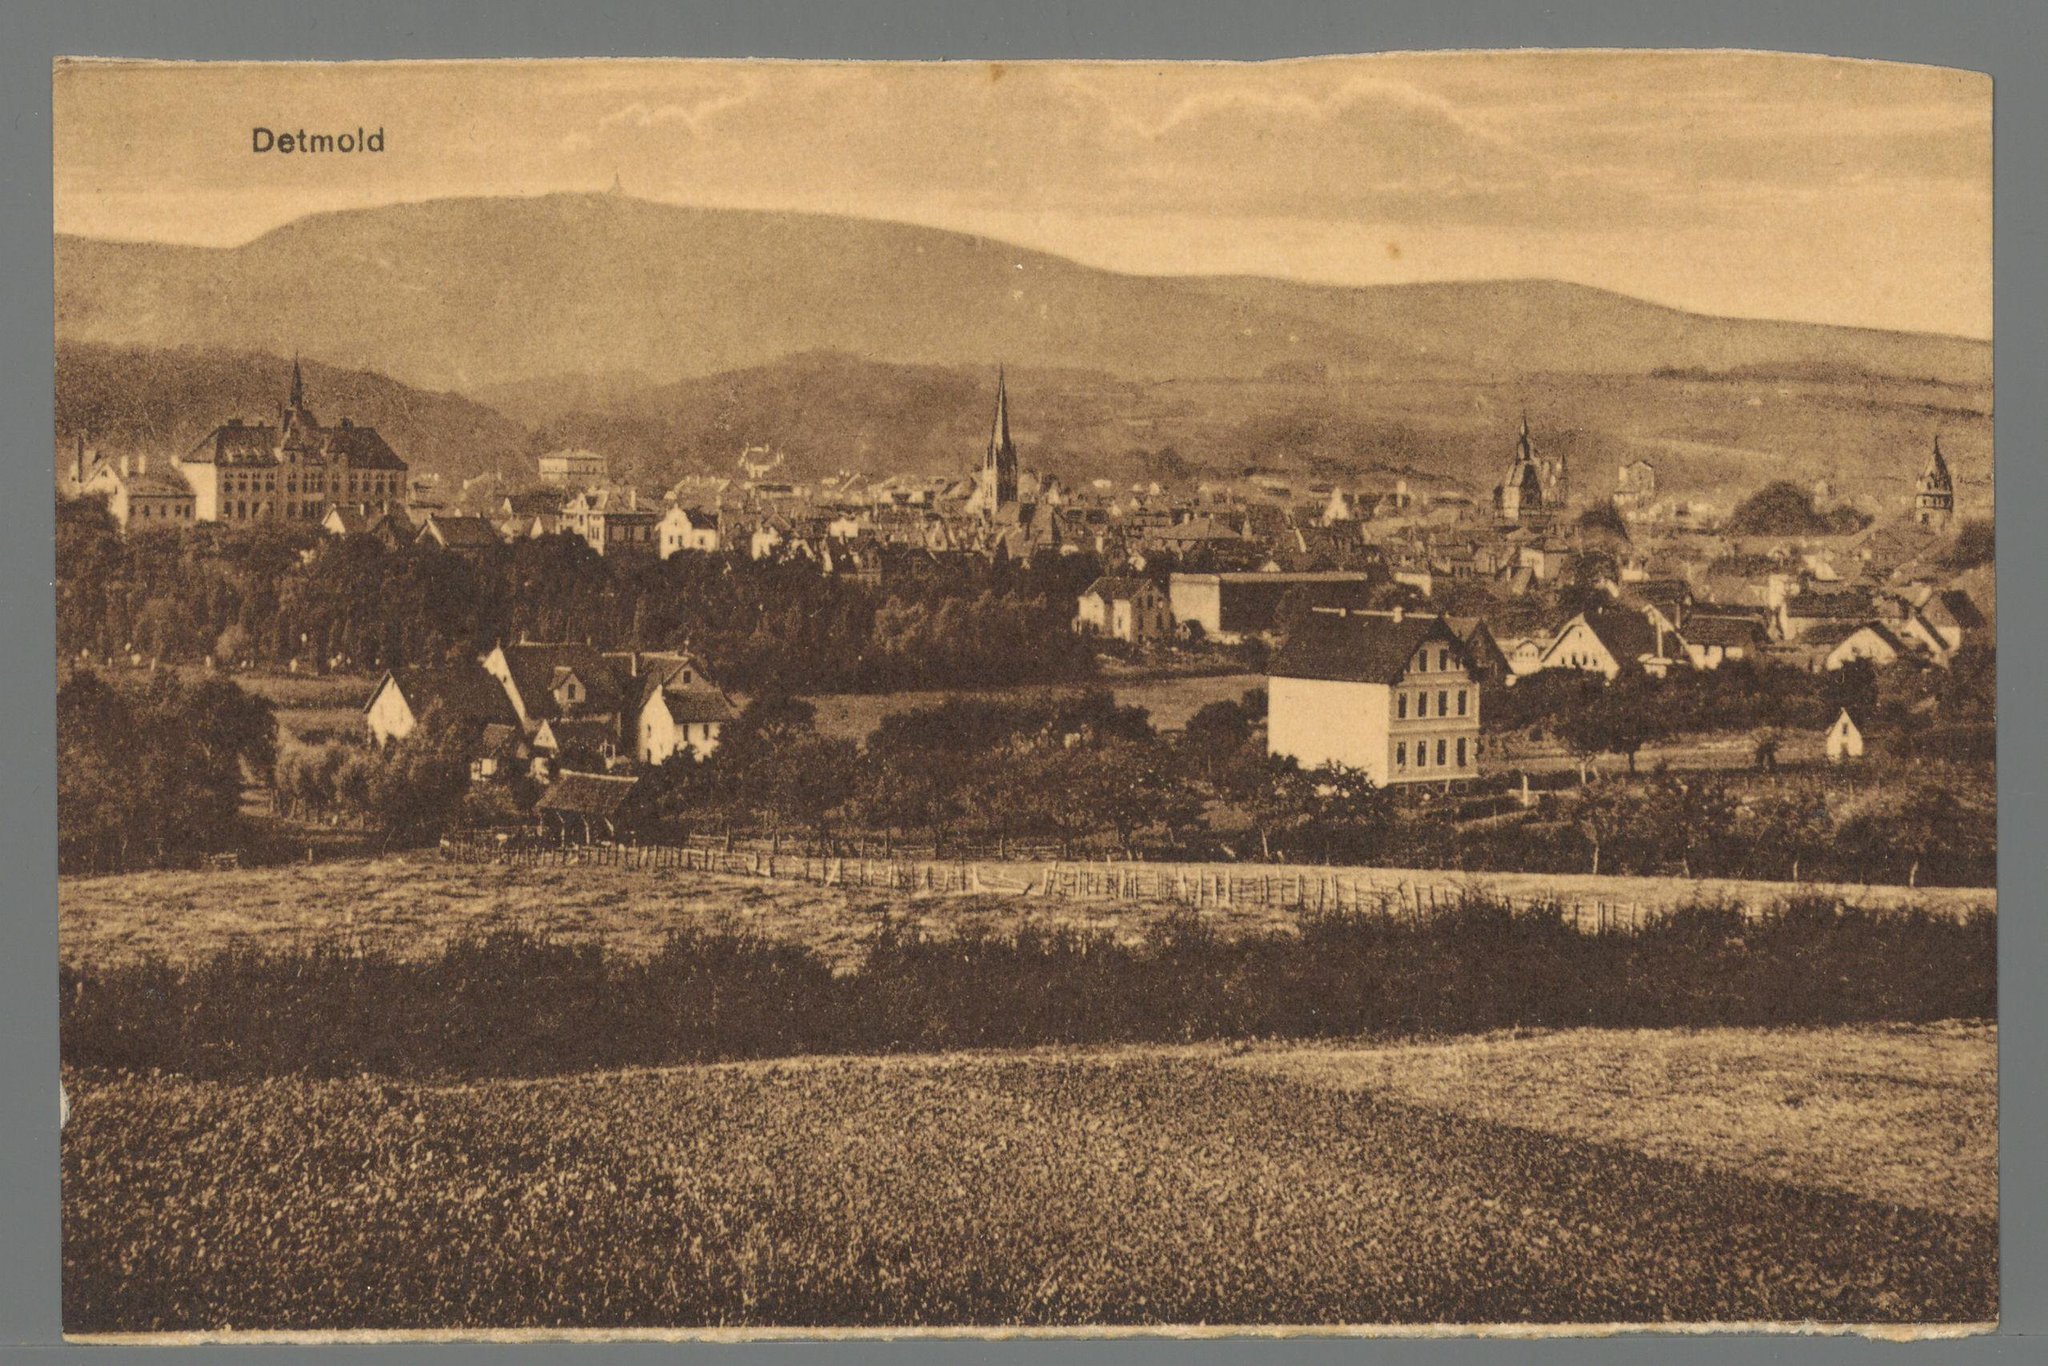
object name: ansichtkaart, prentbriefkaart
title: Detmold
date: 1905-1930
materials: cardboard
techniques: photograph, writing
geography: detmold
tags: city-view, and landscape with man-made constructions